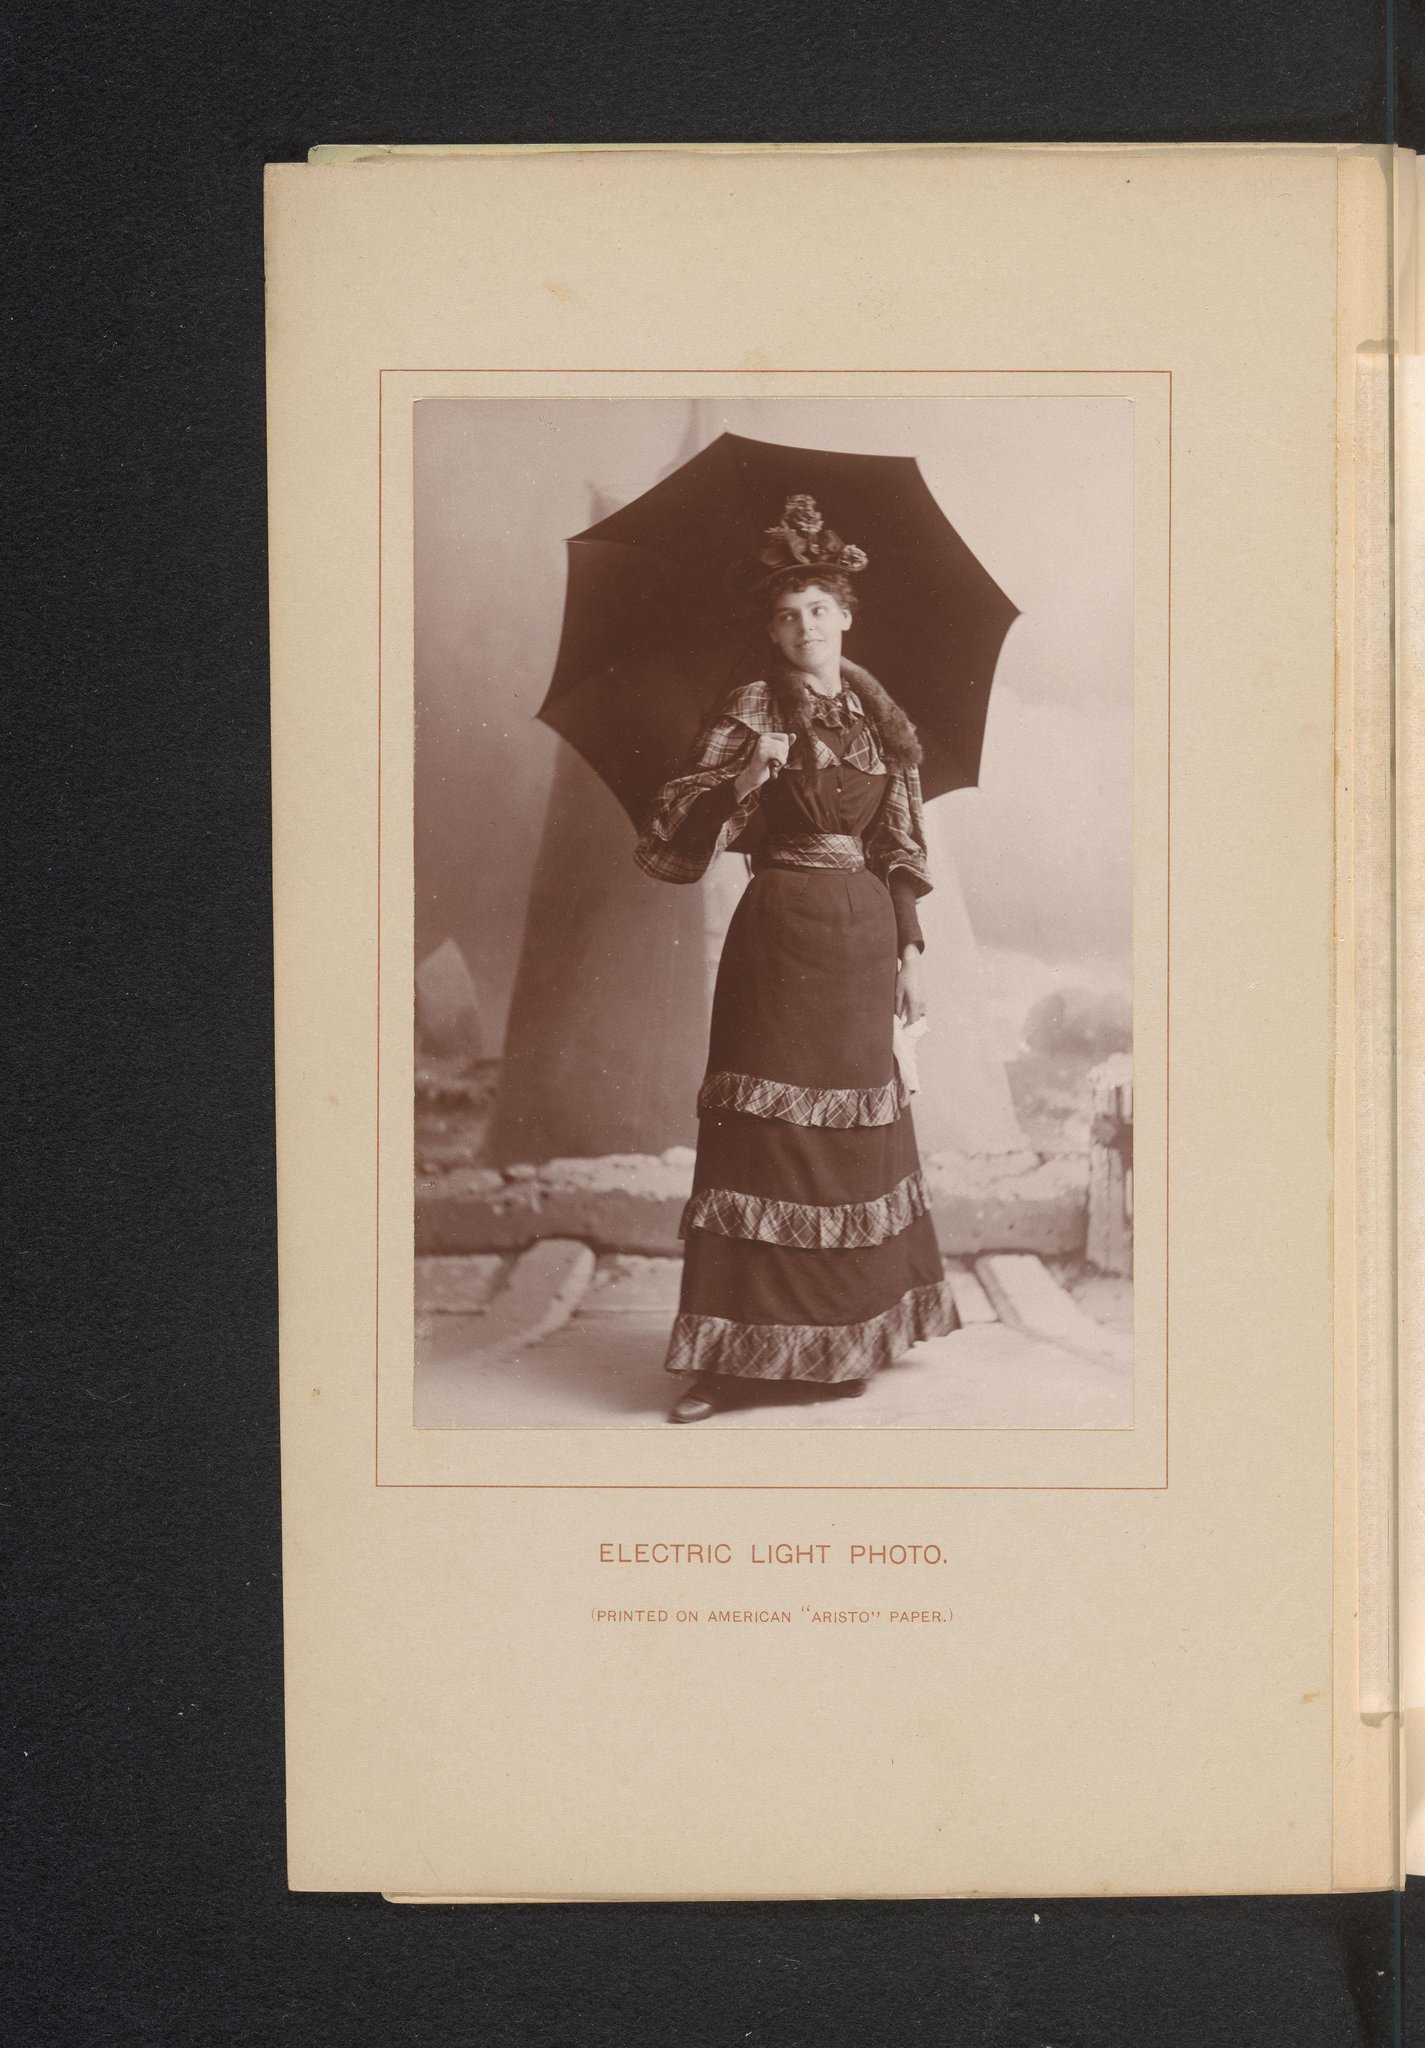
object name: photograph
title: Electric Light Photo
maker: Anonymous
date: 1888-1893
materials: photographic support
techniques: collodion silver print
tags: adult woman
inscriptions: inscription: ‘Pinted on American "Aristo" Paper’